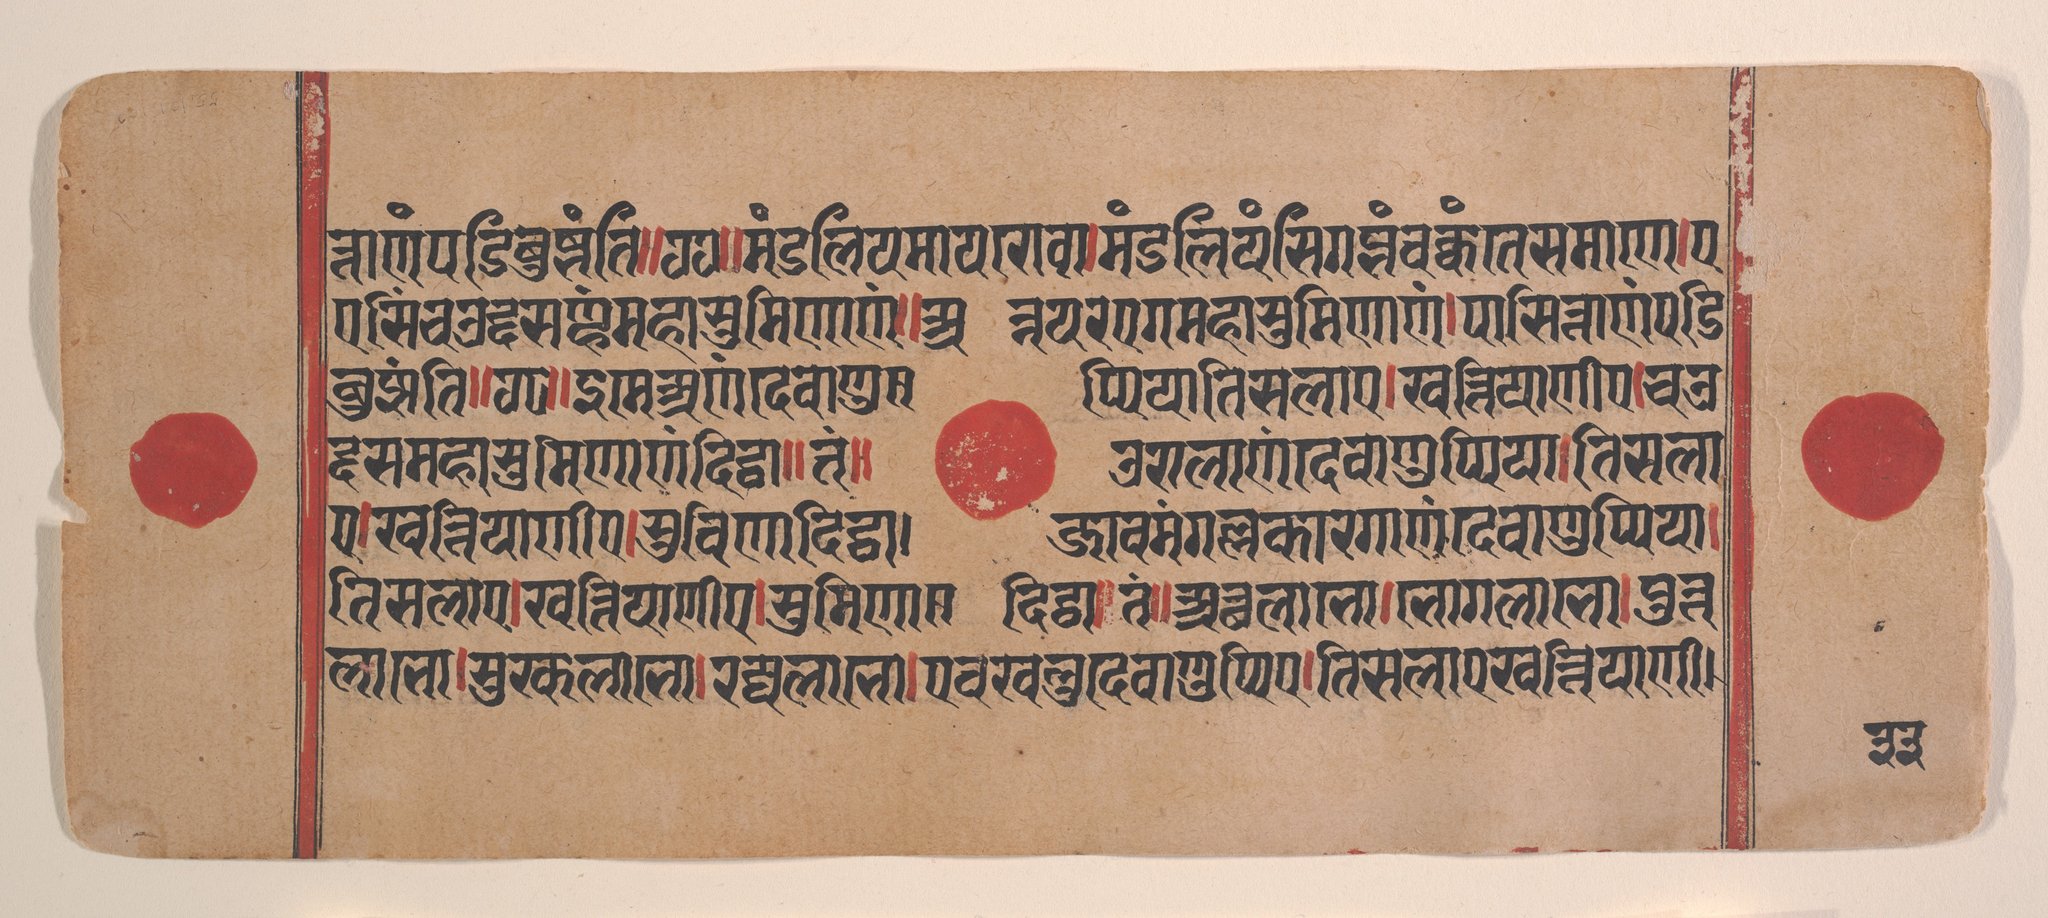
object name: folio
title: Page from a Dispersed Kalpa Sutra (Jain Book of Rituals)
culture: indian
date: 1401-1500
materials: gold, ink, paper, watercolor